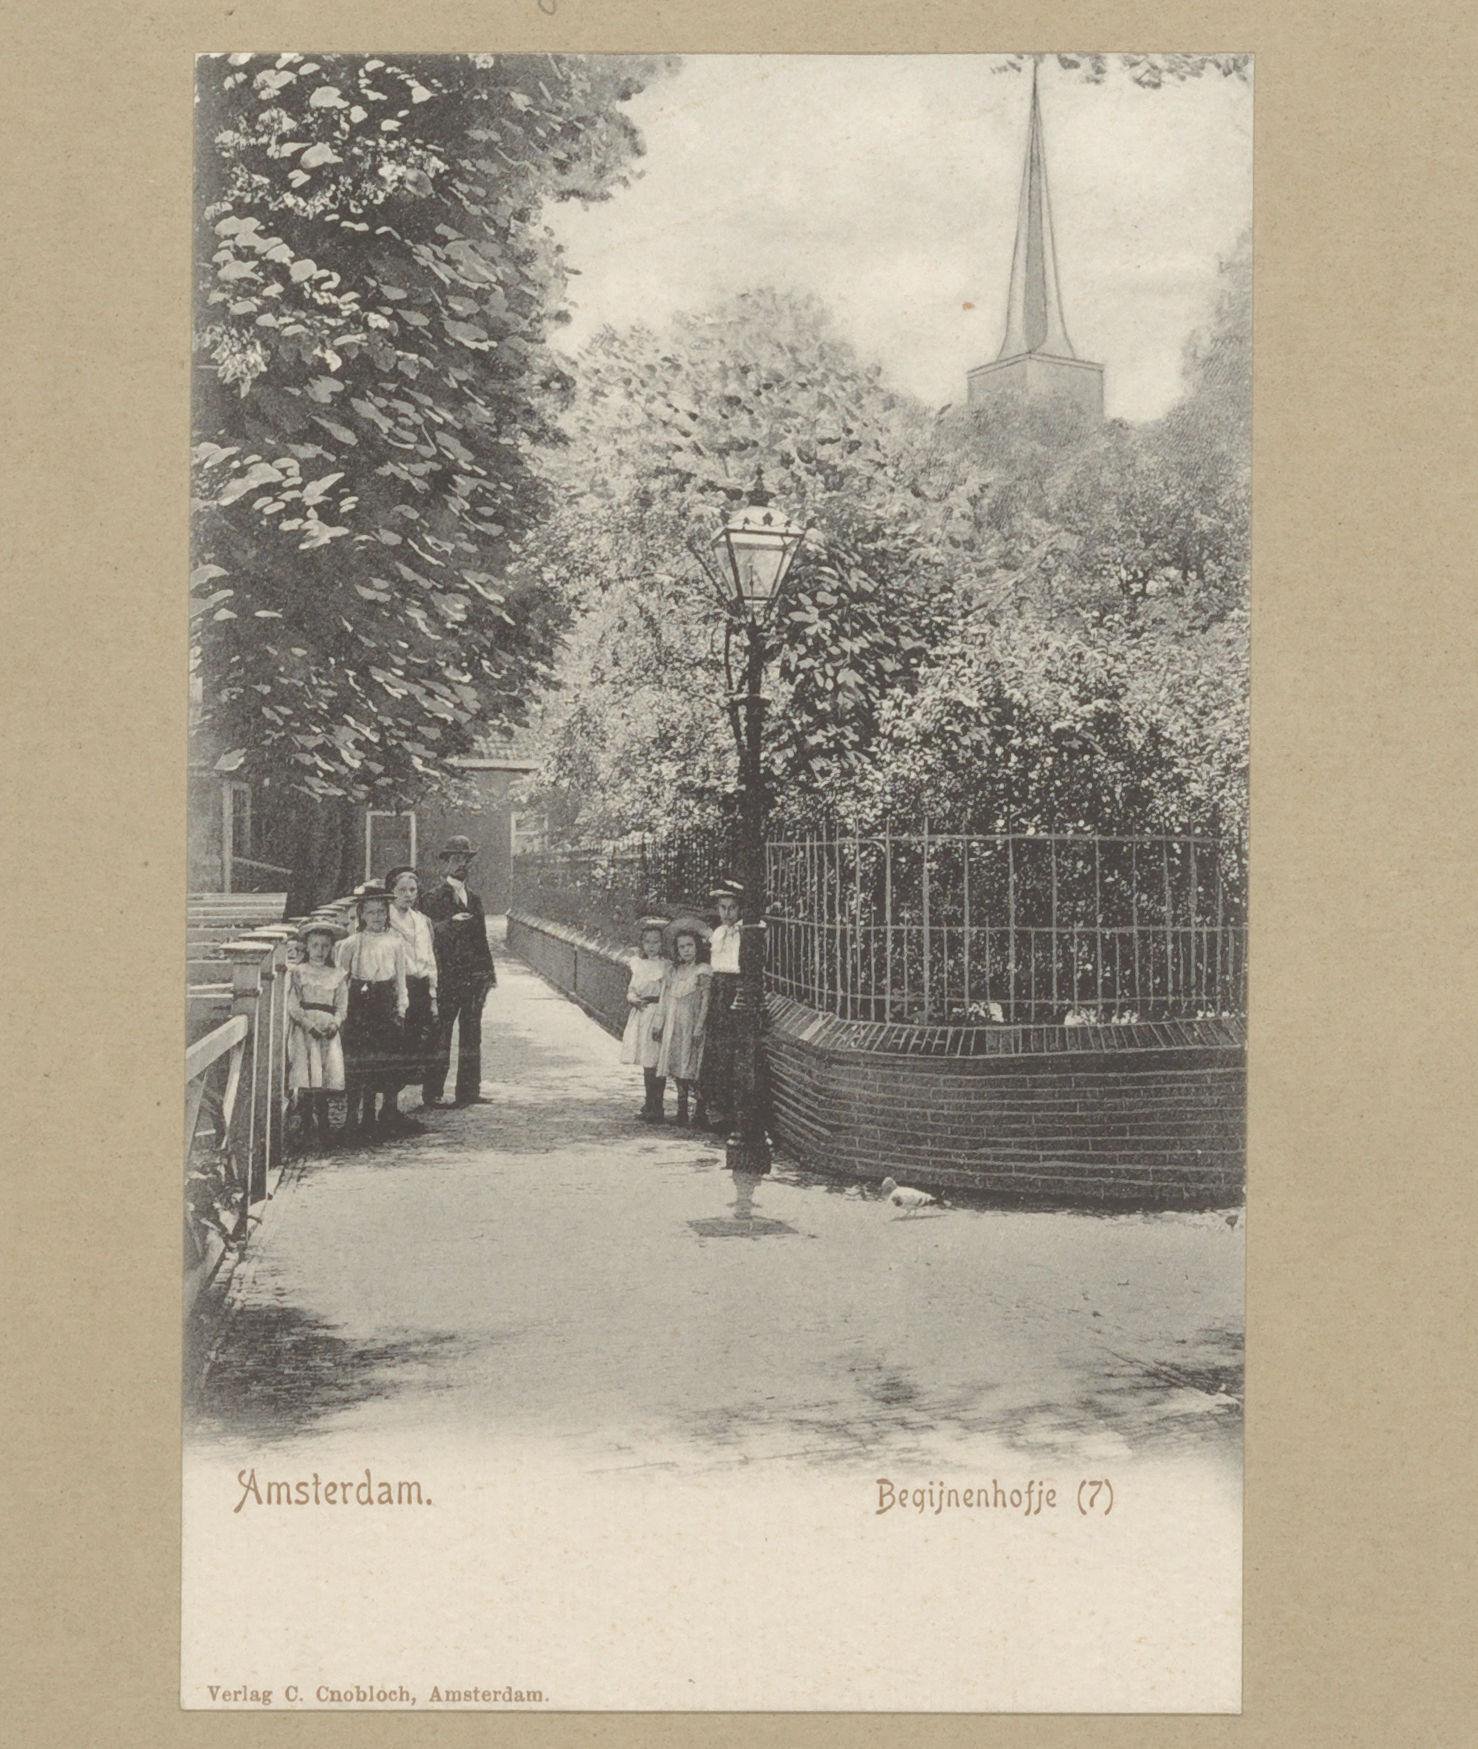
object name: photomechanical print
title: Amsterdam. Begijnenhofje (7)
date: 1892-1905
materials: paper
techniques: photograph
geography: amsterdam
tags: street (+ city(-scape) with figures, staffage)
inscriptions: collector's mark: Lugt 1641b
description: Onderwerpsrubriek binnen de Atlas Amsterdam: Kerkwezen: R.K. Gemeenten: Begijnhof t/m Petrus en Paulus.